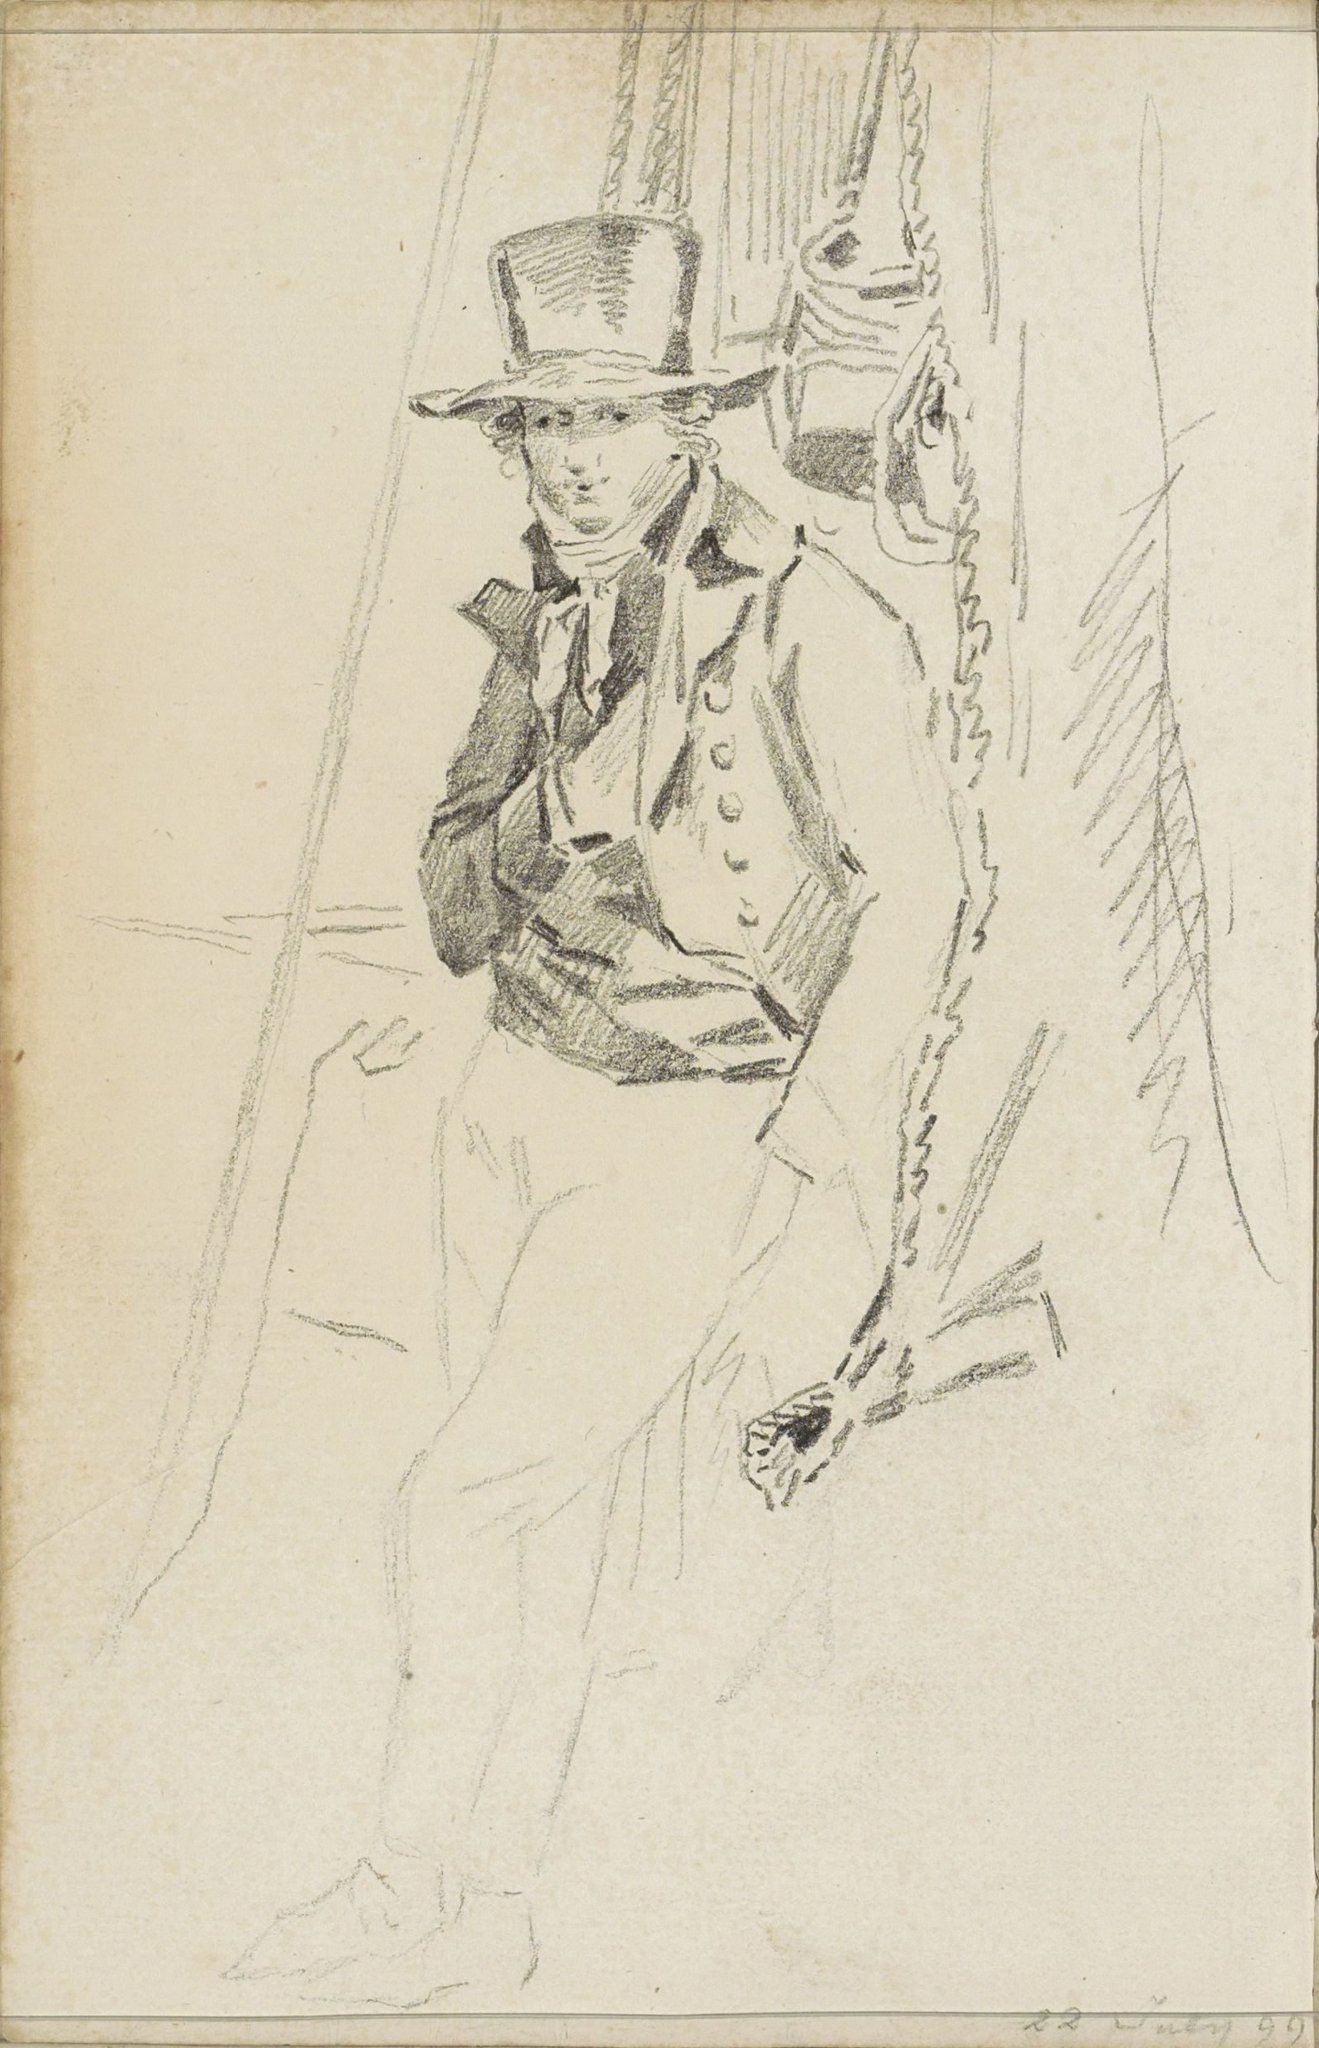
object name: sketchbook leaf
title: Staande man op het dek van een schip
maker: jacob perkois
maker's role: draughtsman, print maker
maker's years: 1756-1804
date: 1707-1799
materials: paper, pencil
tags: standing figure, parts of ship's exterior: deck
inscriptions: date: ‘22 July 99’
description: De man draagt een hoge hoed, heeft zijn rechterhand op de borst en zijn linkerhand in zijn broekzak. Bladzijde 46 uit een schetsboek met 78 bladzijden.